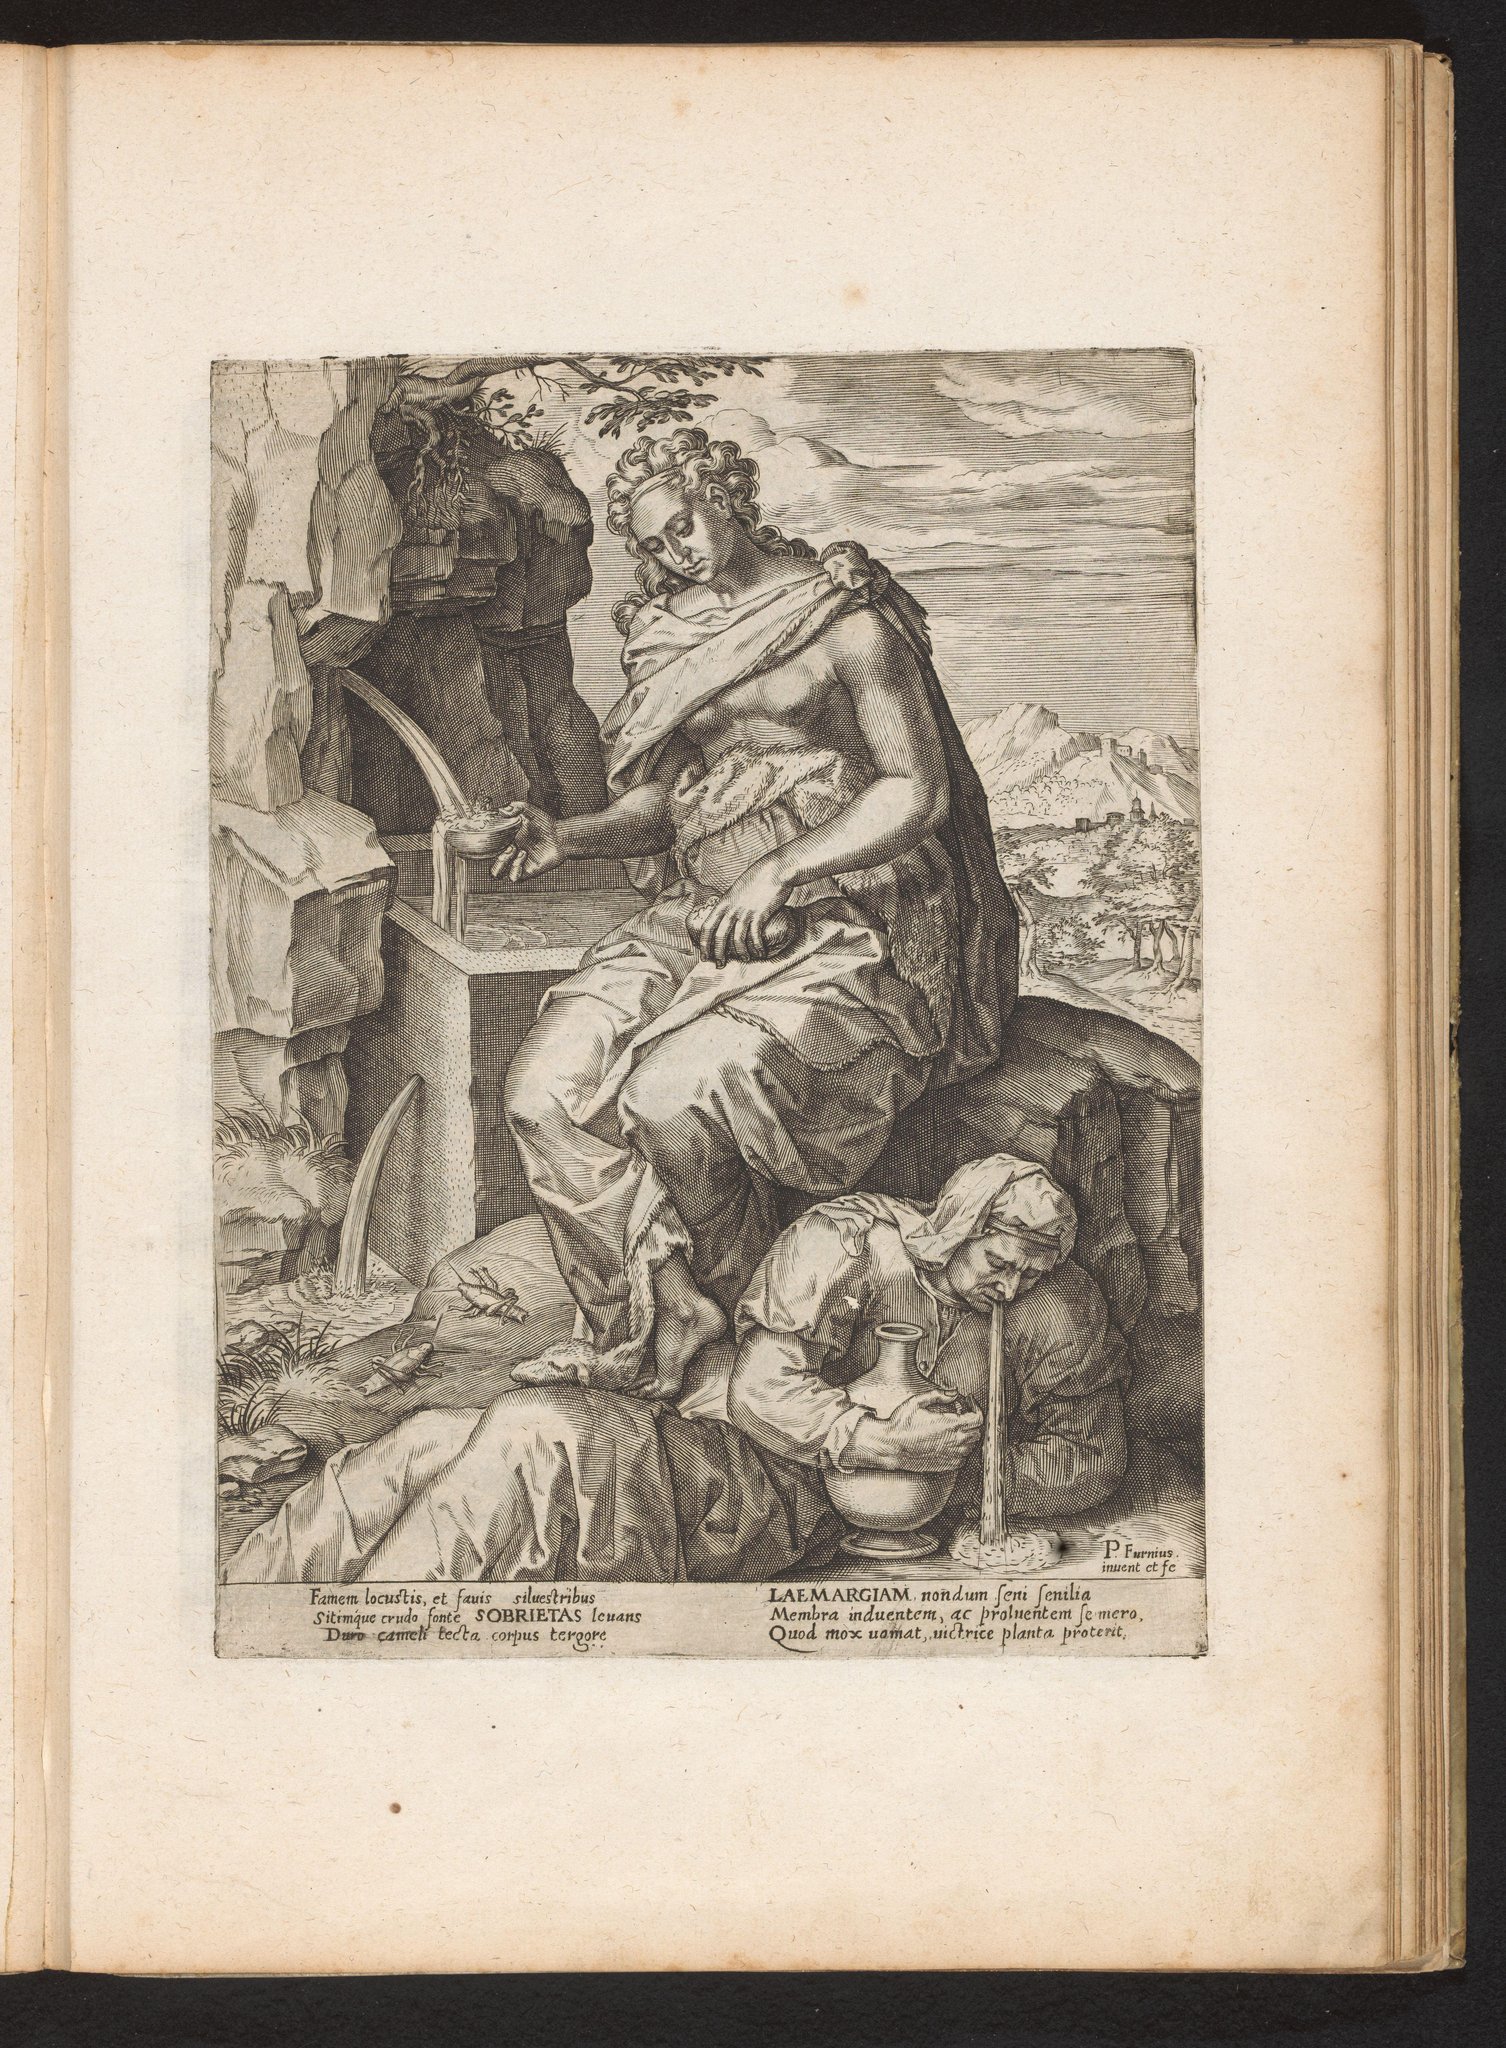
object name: album leaf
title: Gematigdheid overwint Gulzigheid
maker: pieter jalhea furnius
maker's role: print maker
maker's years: 1540-1626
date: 1550-1625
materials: paper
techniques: engraving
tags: temperance, 'temperantia'; 'temperanza' (ripa) ~ one of the four cardinal virtues, gluttony, intemperance, 'gula'; 'gola', 'ingordigia', 'ingordigia overo avidità', 'voracità' (ripa) ~ personification of one of the seven deadly sins, vomiting, one virtue fighting against or treading upon one vice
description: De Gematigdheid vult een drinkschaal bij een bron. Onder haar voeten de overgevende Gulzigheid. Deze prent maakt deel uit van een album.